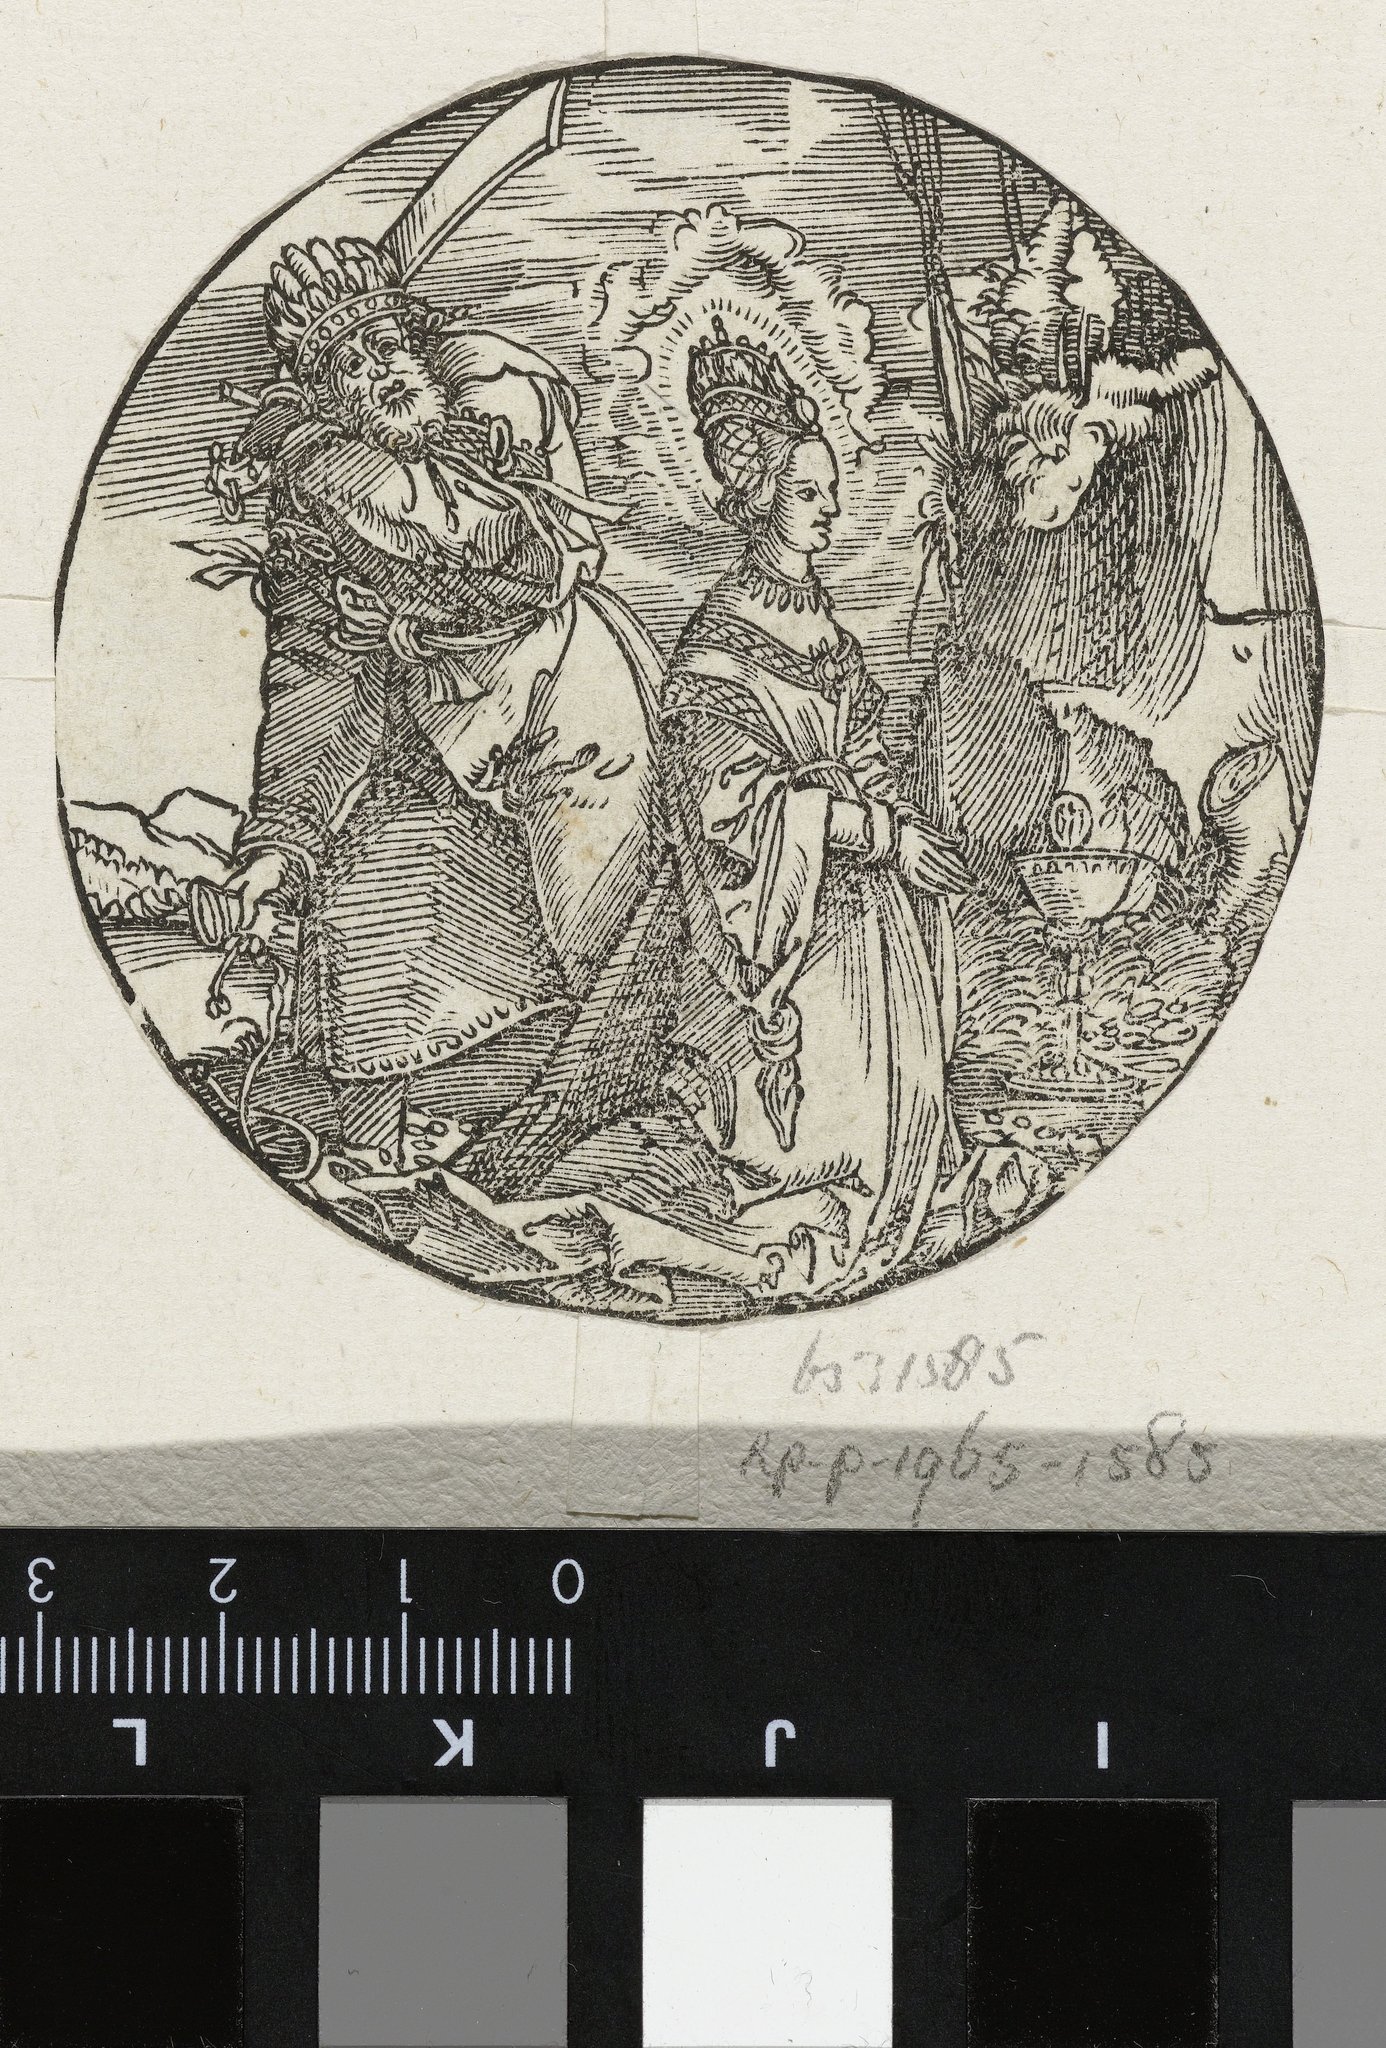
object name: album leaf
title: Martelaarschap van de Heilige Barbara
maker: hans springinklee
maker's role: print maker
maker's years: -1540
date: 1505-1540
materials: paper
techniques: woodcut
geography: nuremberg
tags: st. barbara is beheaded by her father dioscuros, who usually wears a turban and brandishes a scimitar (sword); sometimes dioscuros is struck by lightning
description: Ronde voorstelling van de Heilige Barbara die in de buitenlucht knielt voor een miskelk waaruit een hostie verschijnt. Haar vader staat met getrokken zwaard achter haar. Prent maakt deel uit van een album.